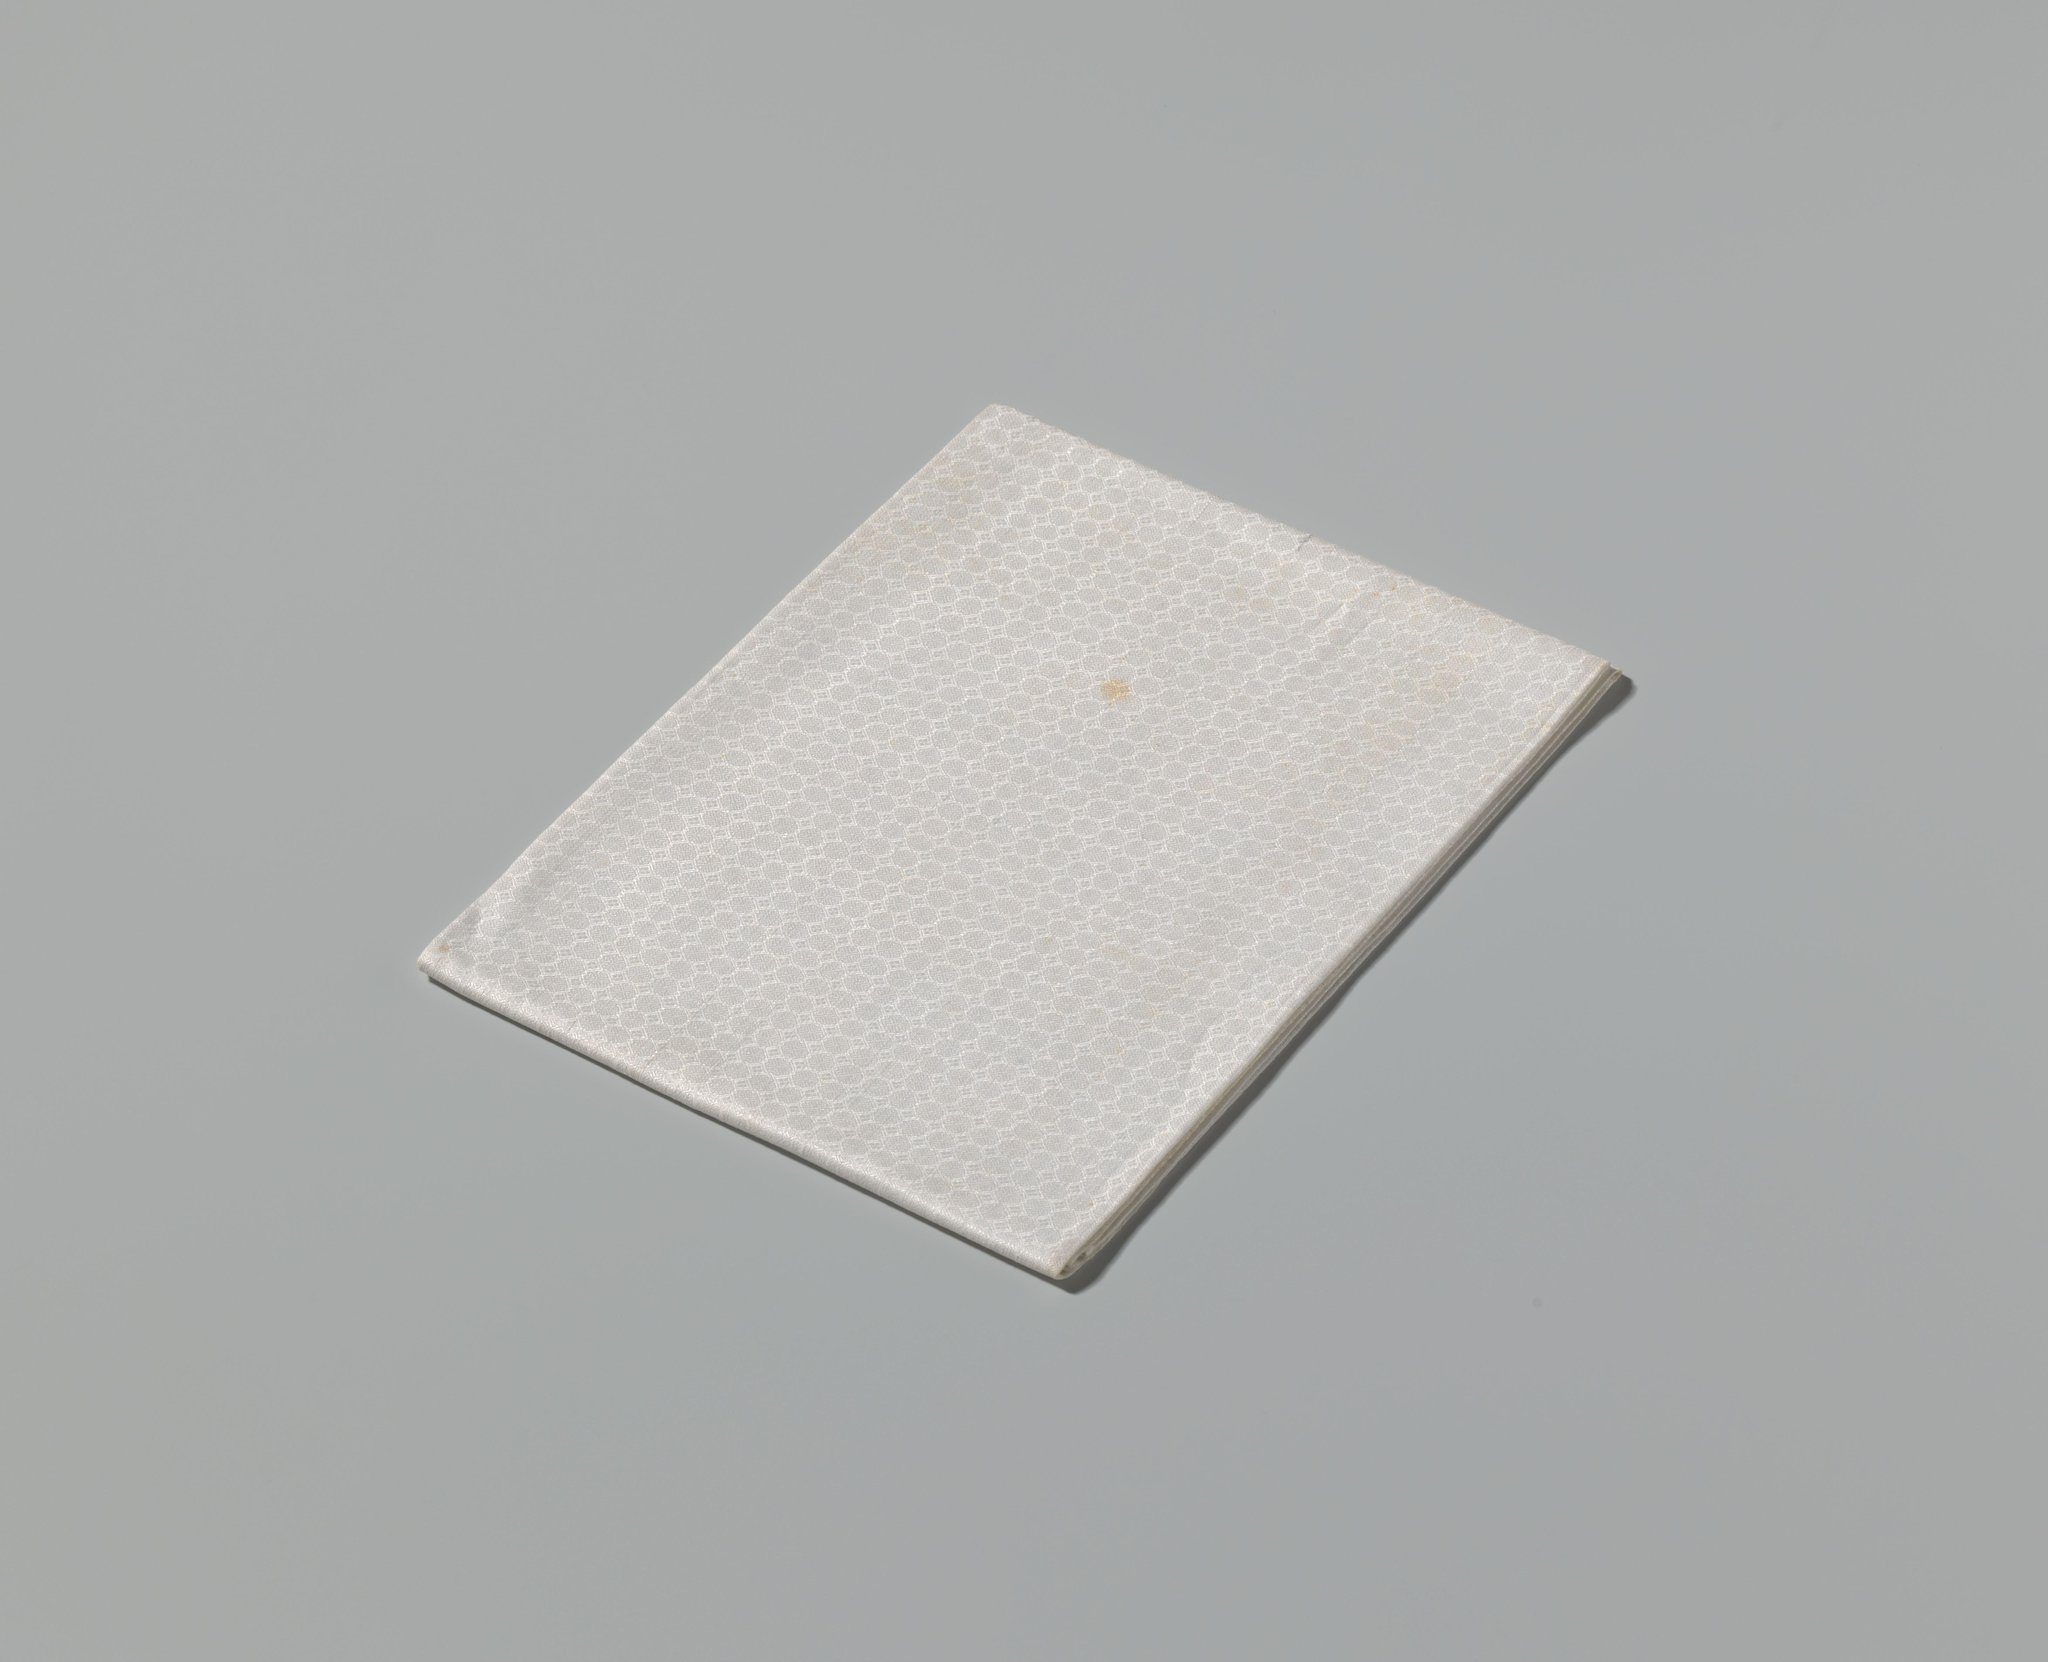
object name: napkin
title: Servet van wit linnen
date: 1731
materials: linen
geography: northern netherlands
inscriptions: date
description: Wit linnen servet met kruiswerkpatroon "lavendel" of "kaffen Roosjes". Merk kroon WG 30 en 1731.